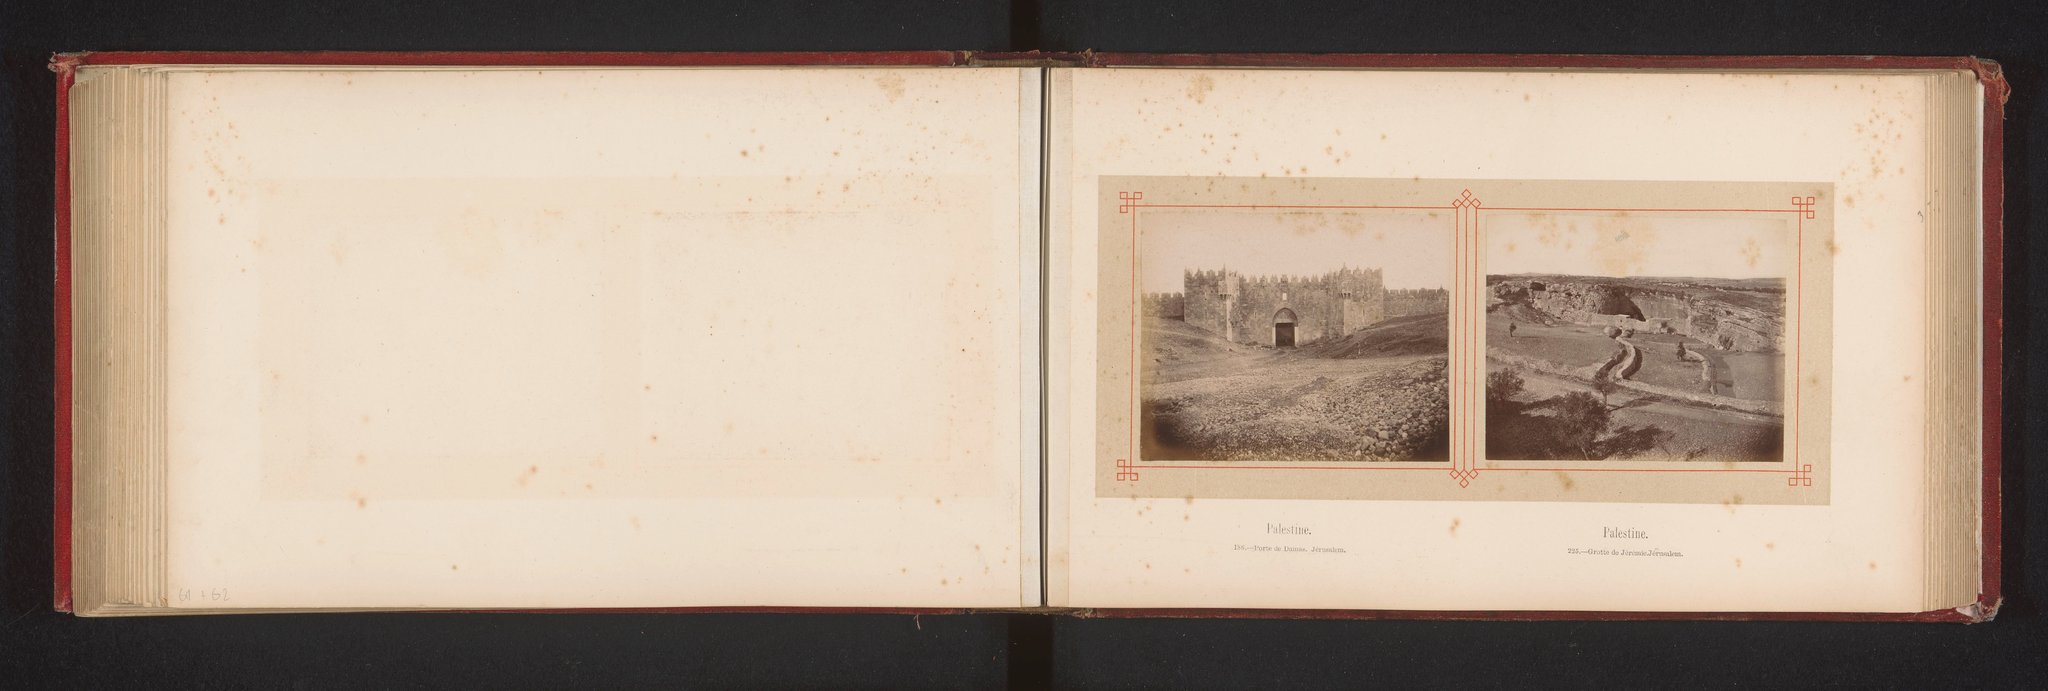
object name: page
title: Damascus Poort te Jeruzalem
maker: félix bonfils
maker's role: fotograaf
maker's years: 1831-1885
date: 1873-1878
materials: photographic support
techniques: albumen print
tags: gate, entrance